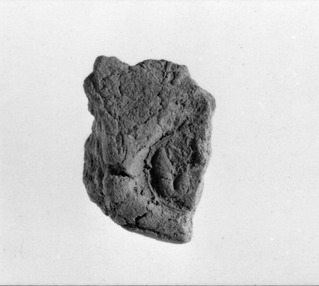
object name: sealing, nebmaatre, amenhotep iii, thoth, double crown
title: Document Sealing With the Throne Name of Amenhotep III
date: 1390-1352 BCE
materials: mud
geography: egypt